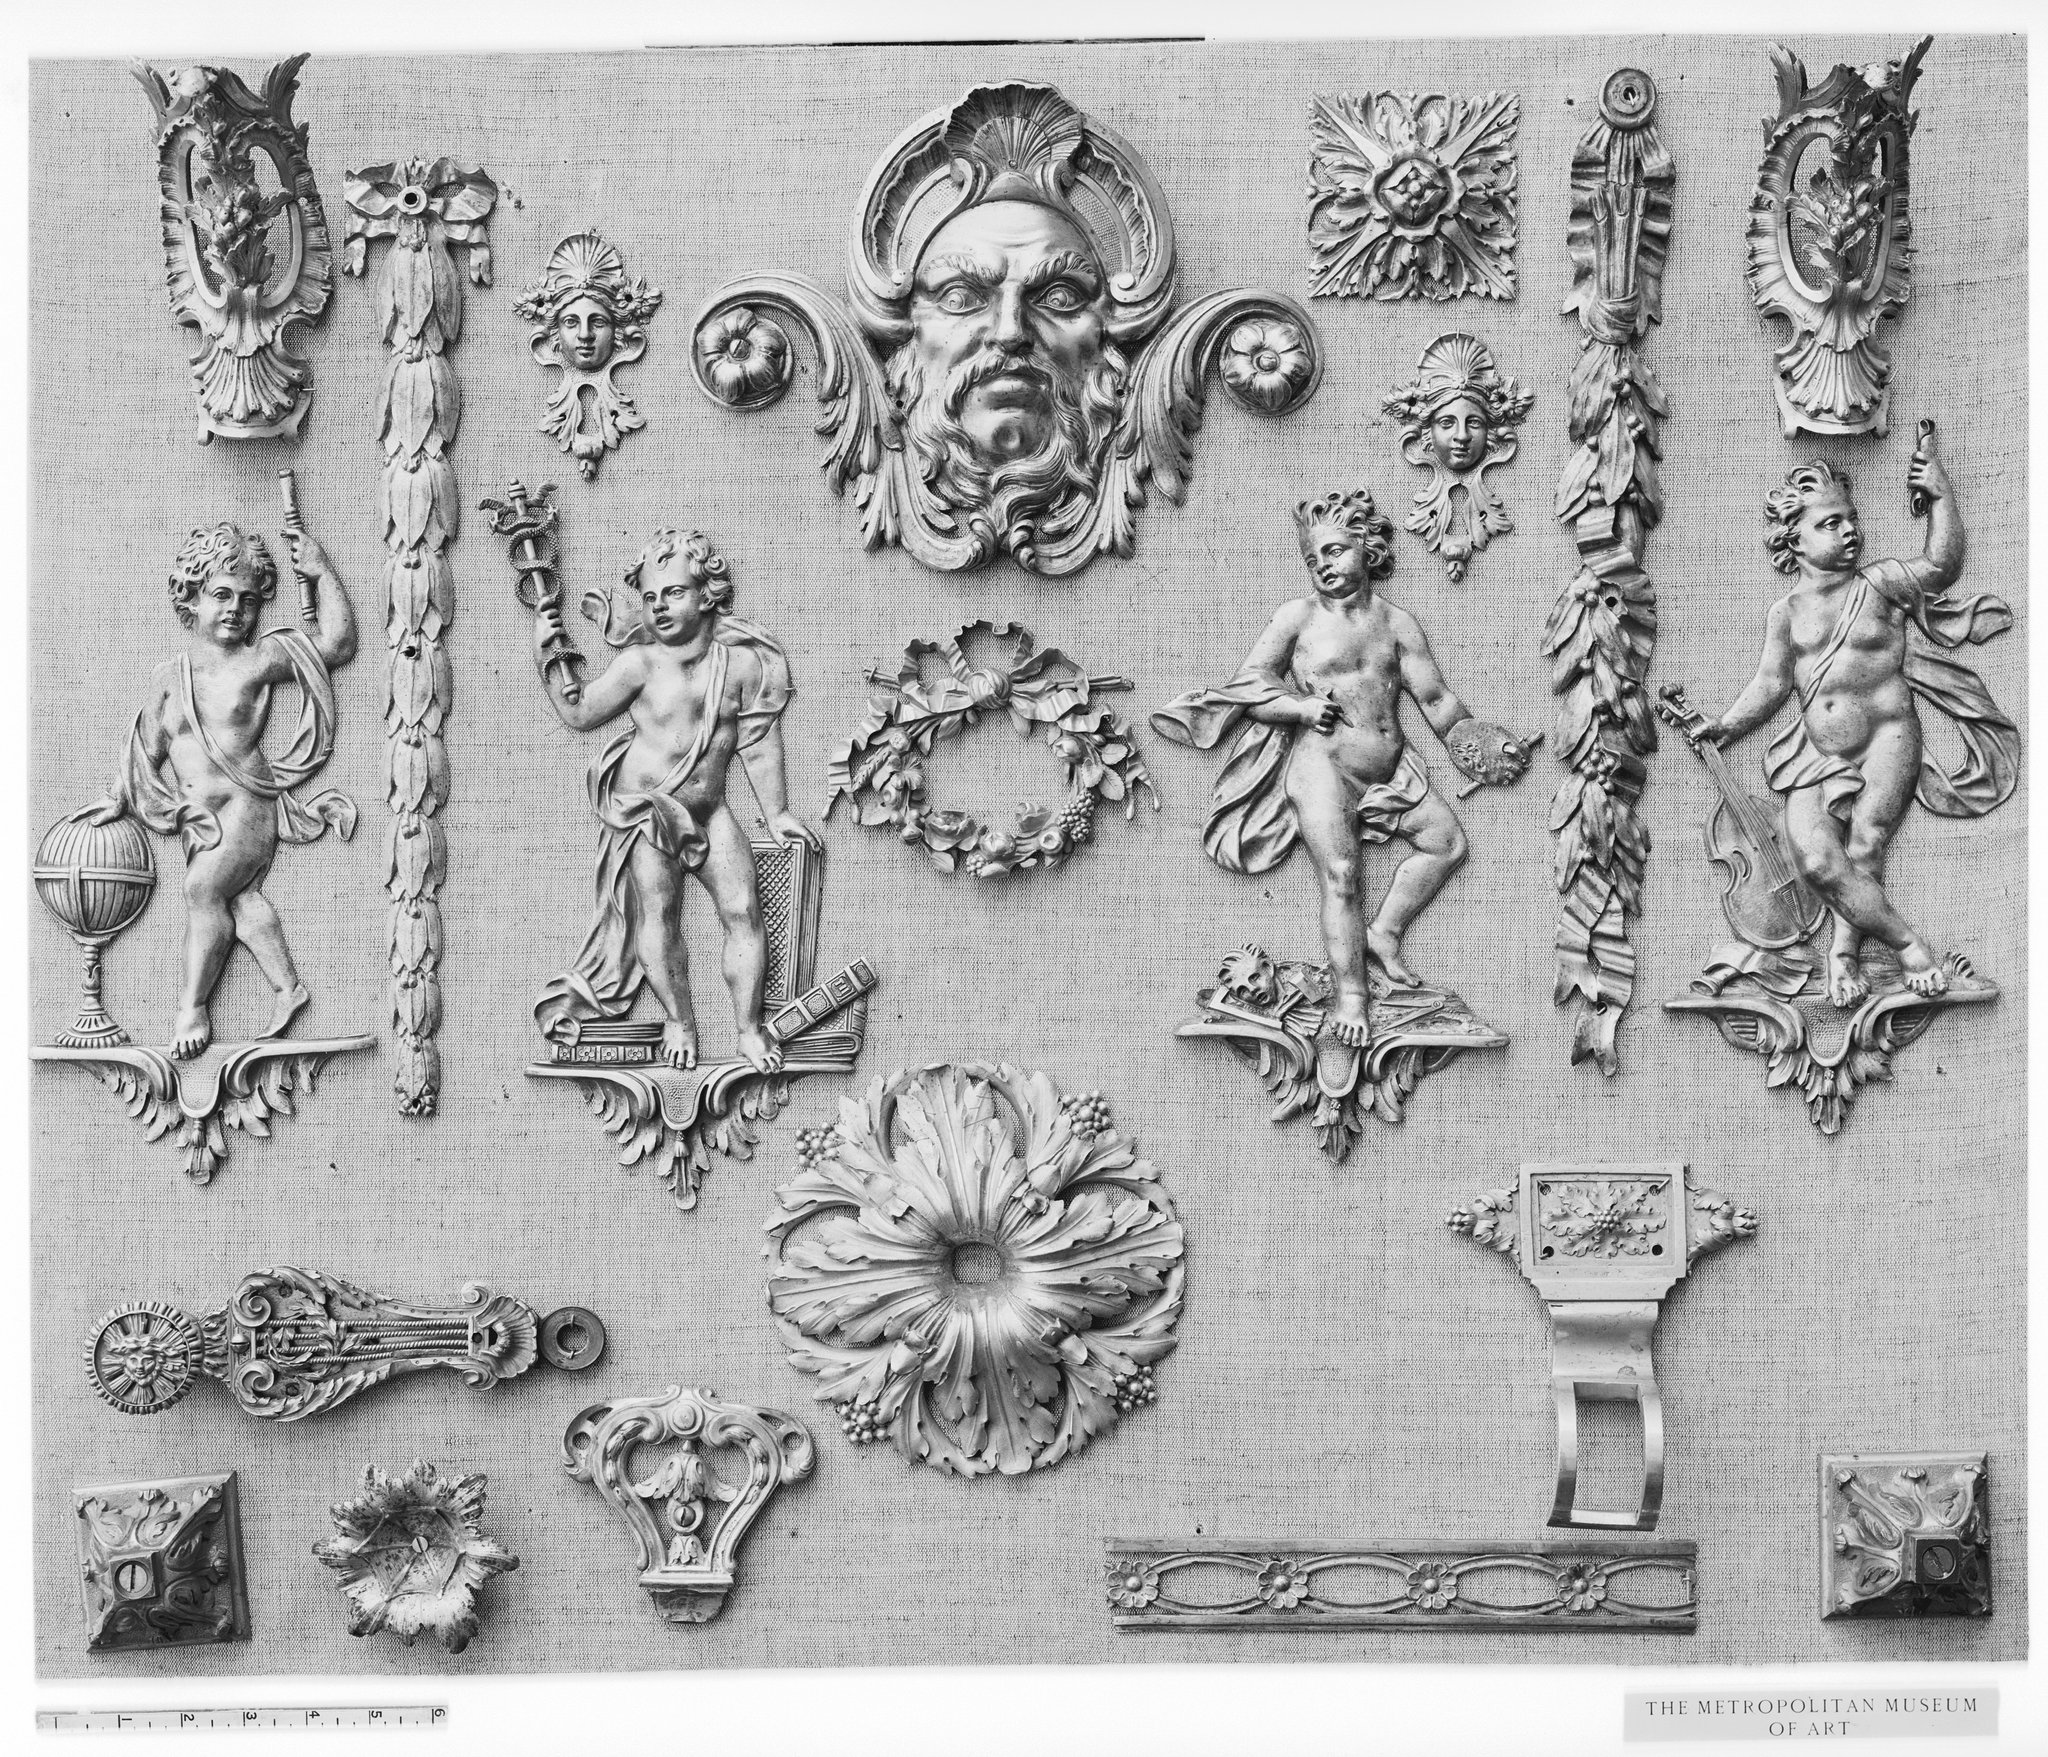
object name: chute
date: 1701-1800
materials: gilt bronze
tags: male nudes,women,flowers,wreaths